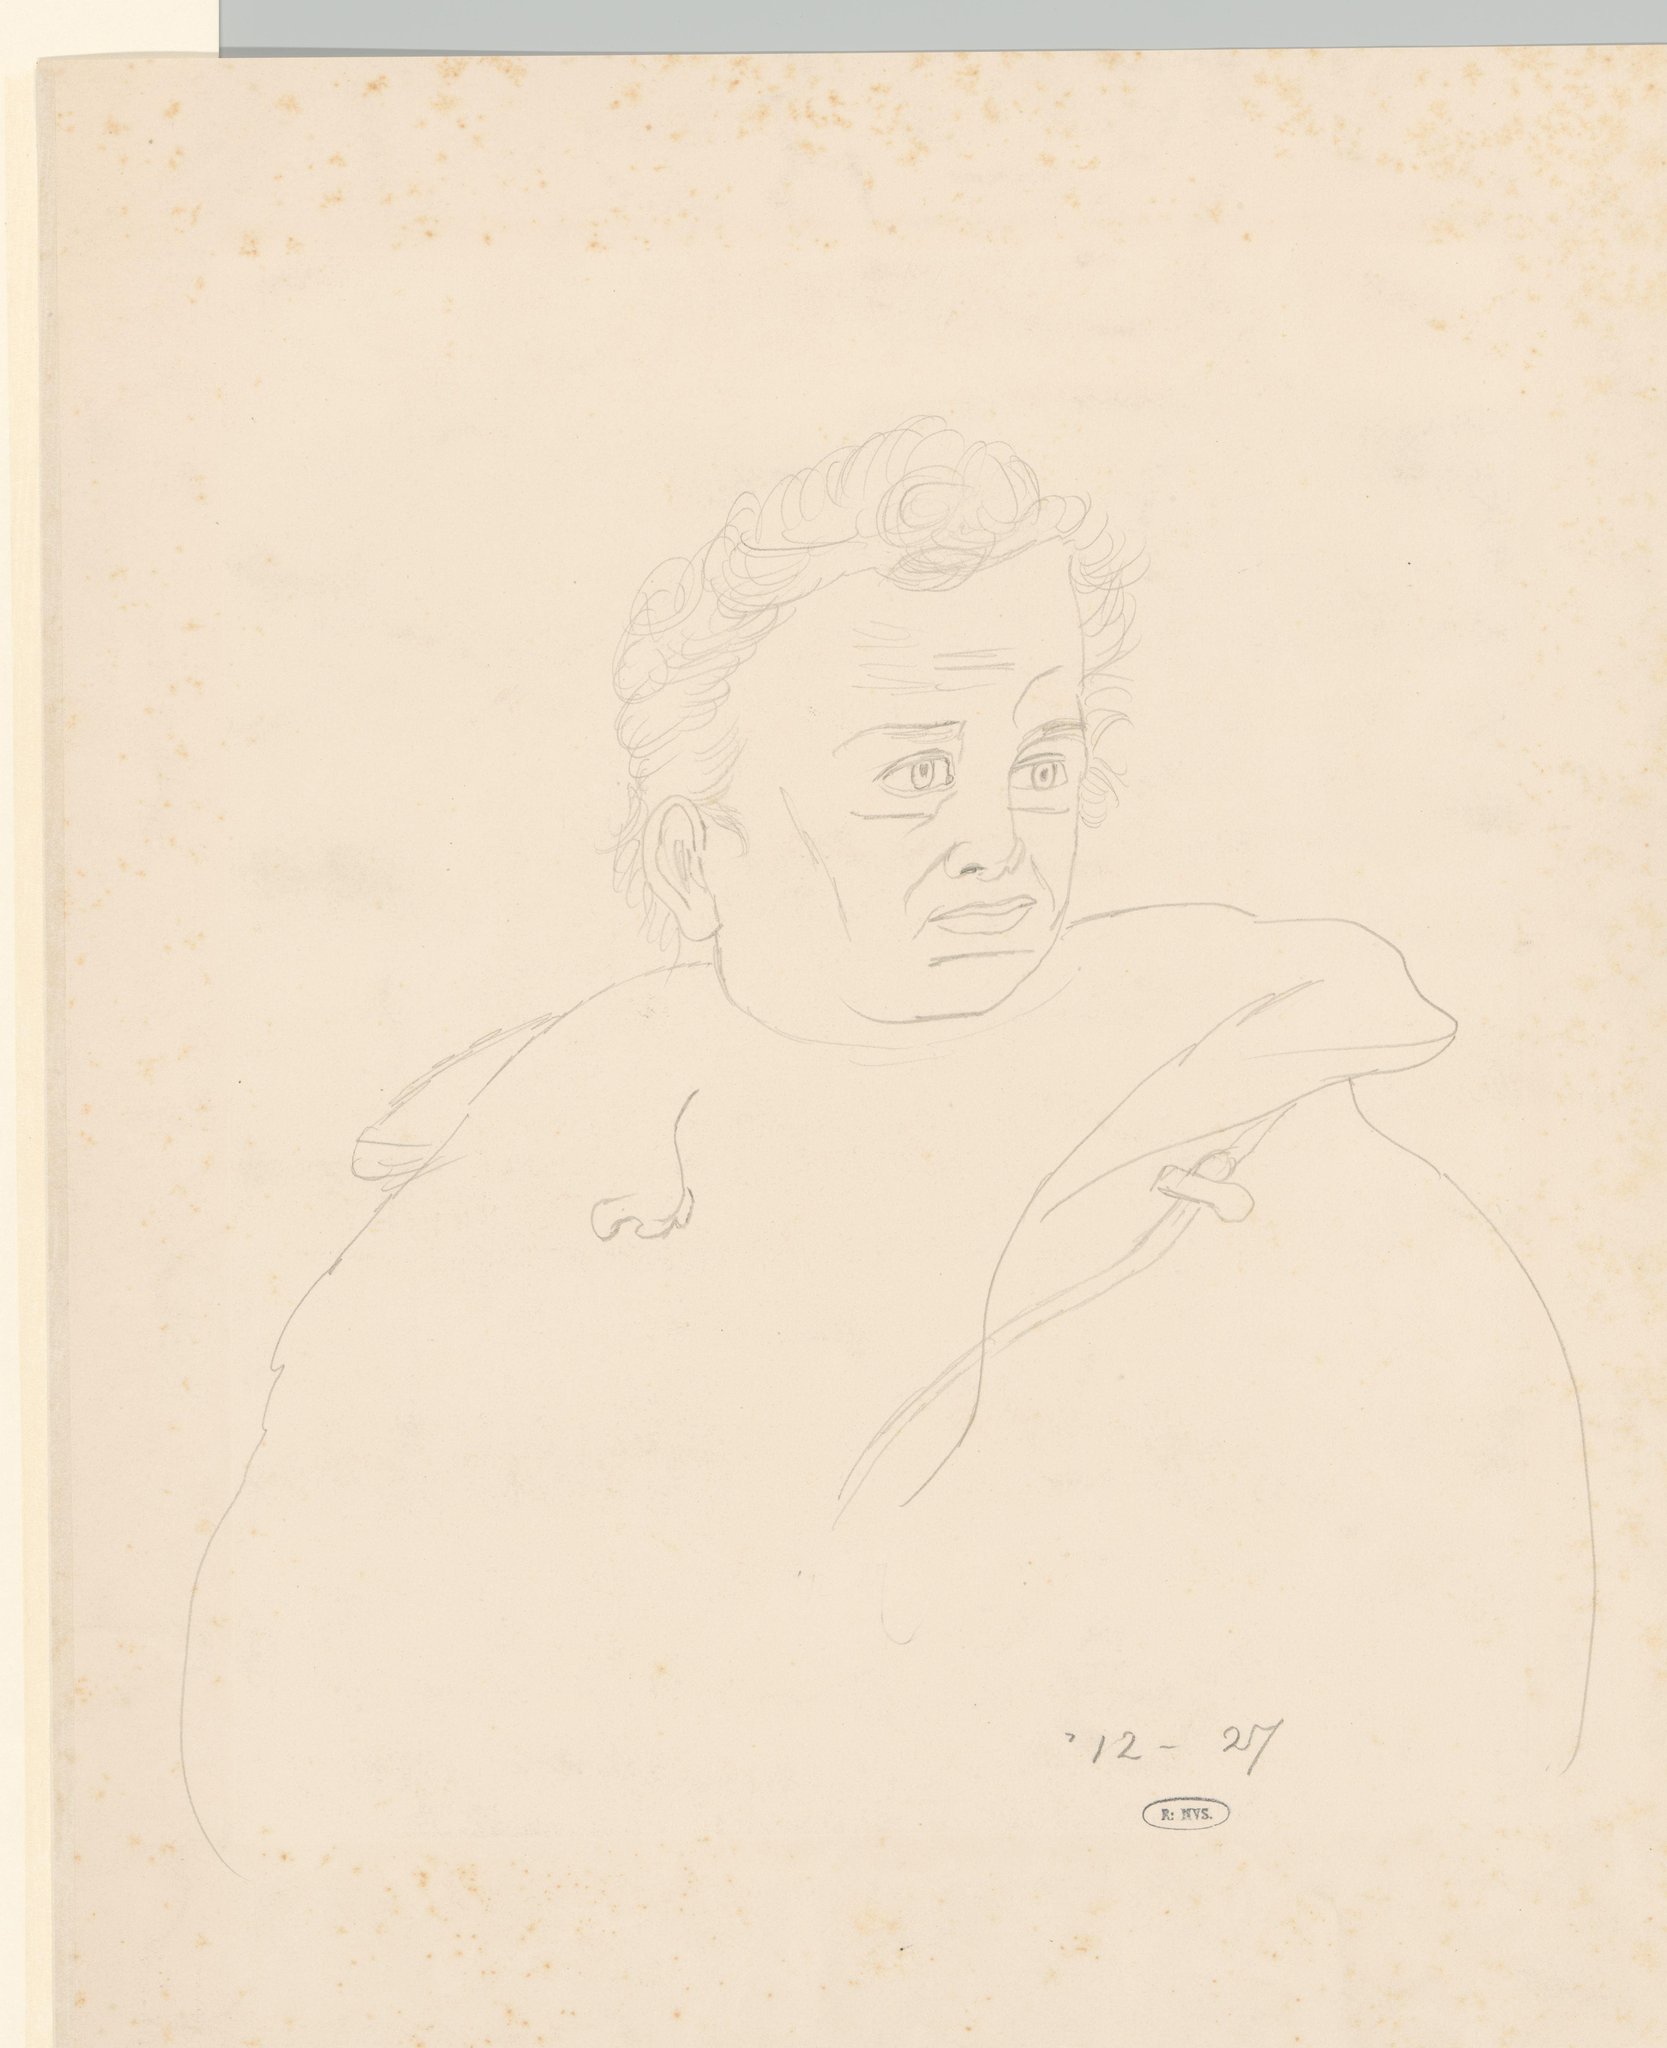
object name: print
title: Portret van een man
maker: Anonymous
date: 1809-1912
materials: paper, pencil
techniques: drawing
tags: historical persons (+ (full) bust portrait)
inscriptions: collector's mark: Lugt 2228